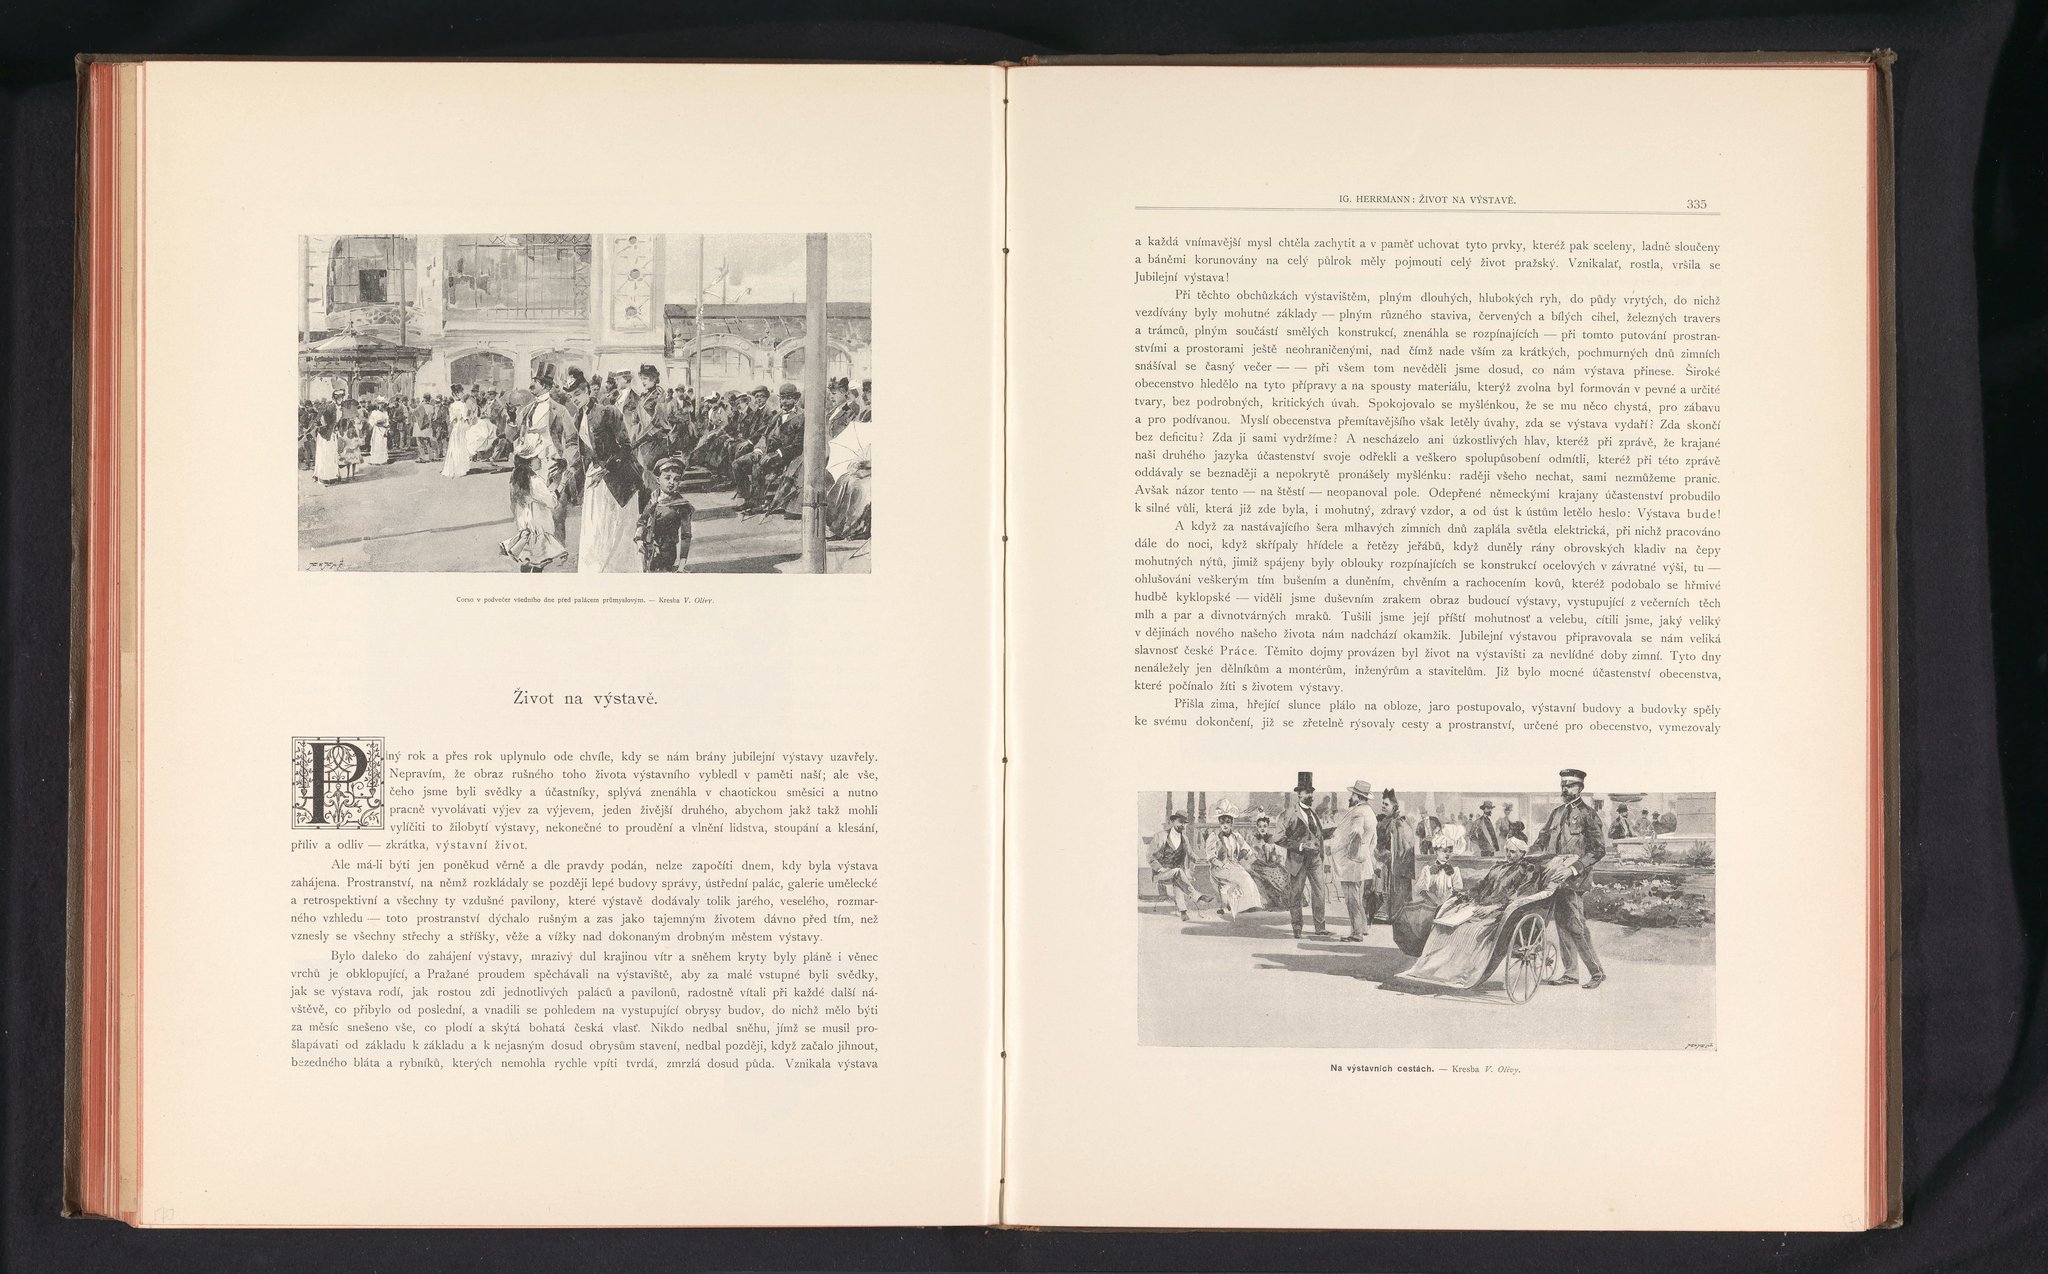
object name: reproduction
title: Na výstavních cestách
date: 1891-1893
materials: paper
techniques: autotype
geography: prague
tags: public festivities, temporary exhibition, 'salon'